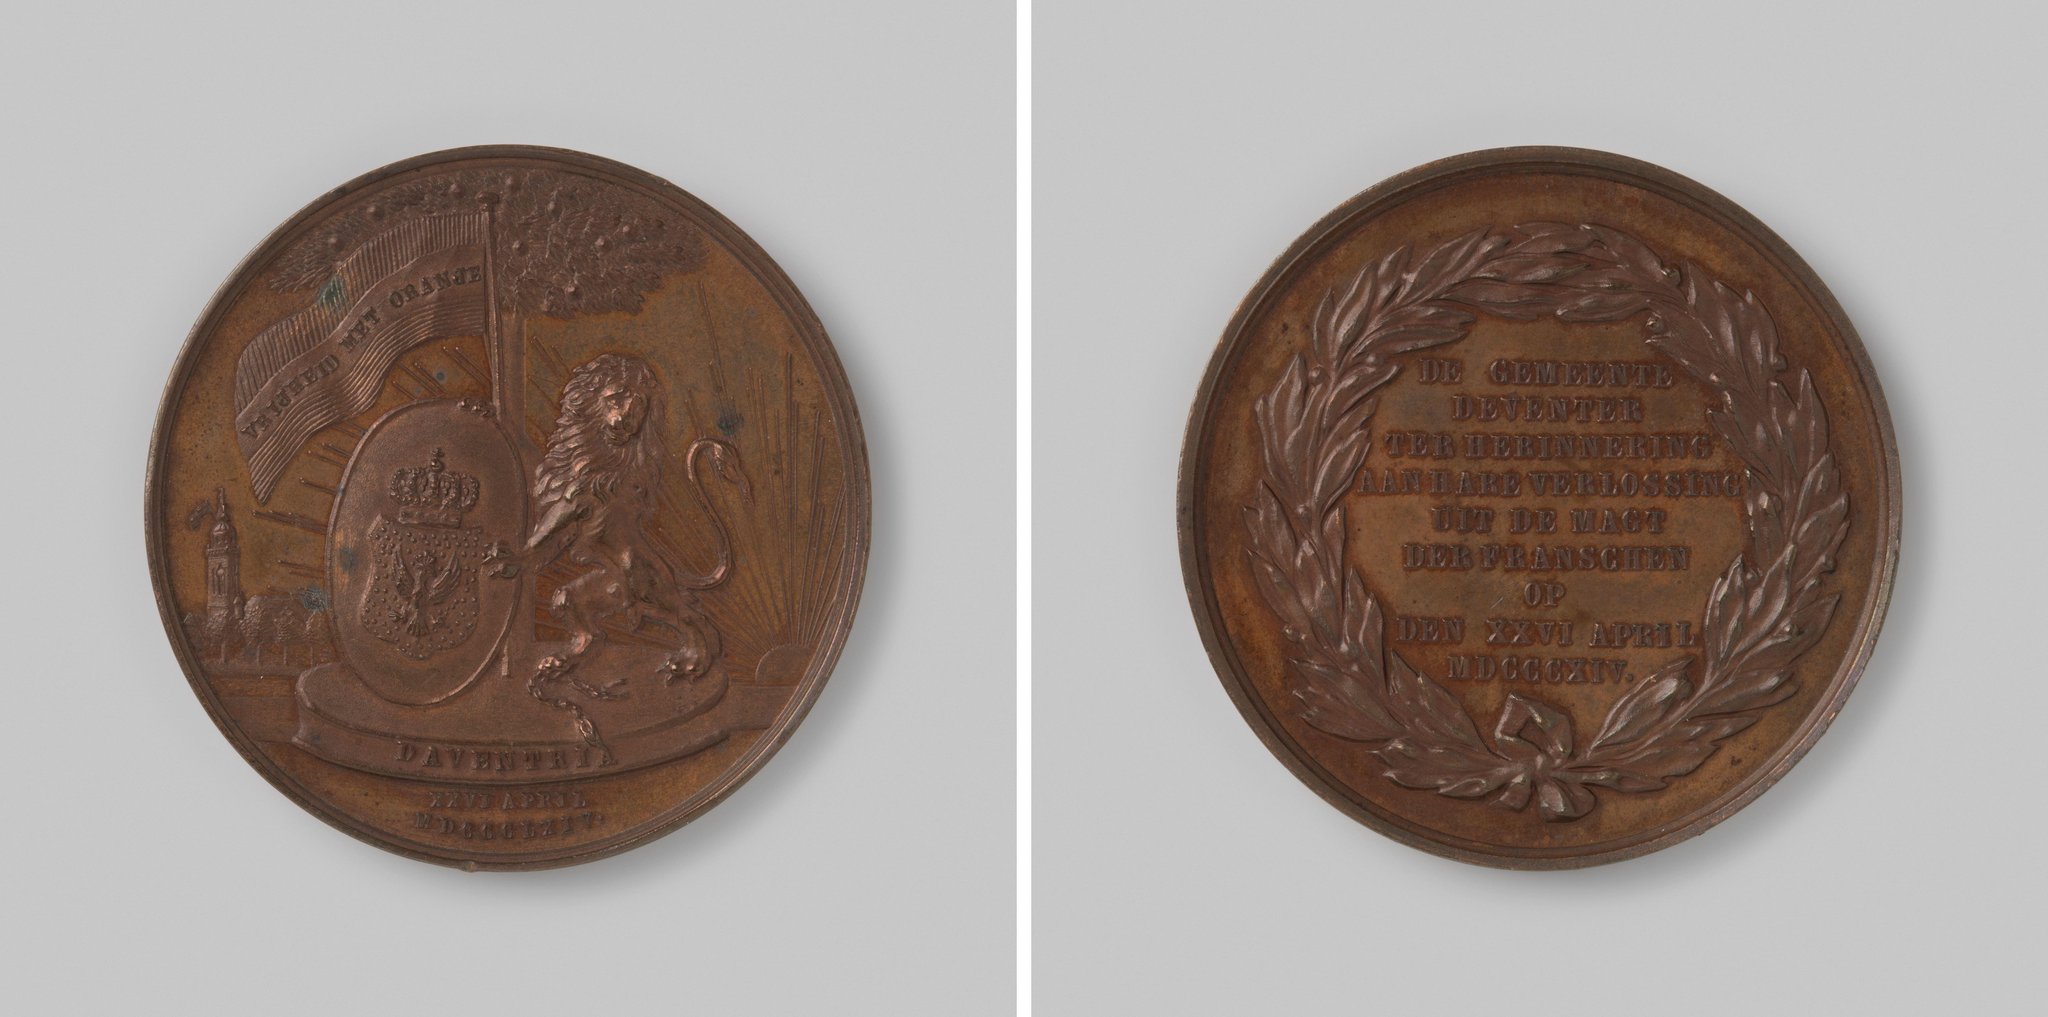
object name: history medal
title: Vijftigjarige herdenking van de bevrijding van Deventer 1864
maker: david van der kellen (1804-1879)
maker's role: die cutter, draughtsman, print maker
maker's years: 1804-1879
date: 1864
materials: bronze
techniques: striking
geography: utrecht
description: Bronzen penning, op de voorzijde de Nederlandse Leeuw met een schild waarop het gekroonde Deventer wapenschild en een vaandel met opschrift, onder een oranjeboom tussen het aanzicht van Deventer en een opgaande zon, met afsnedetekst, op de keerzijde negen regels tekst tussen samengestrikte lauwertakkebn. Rand ingestempeld mercuriusstaf.